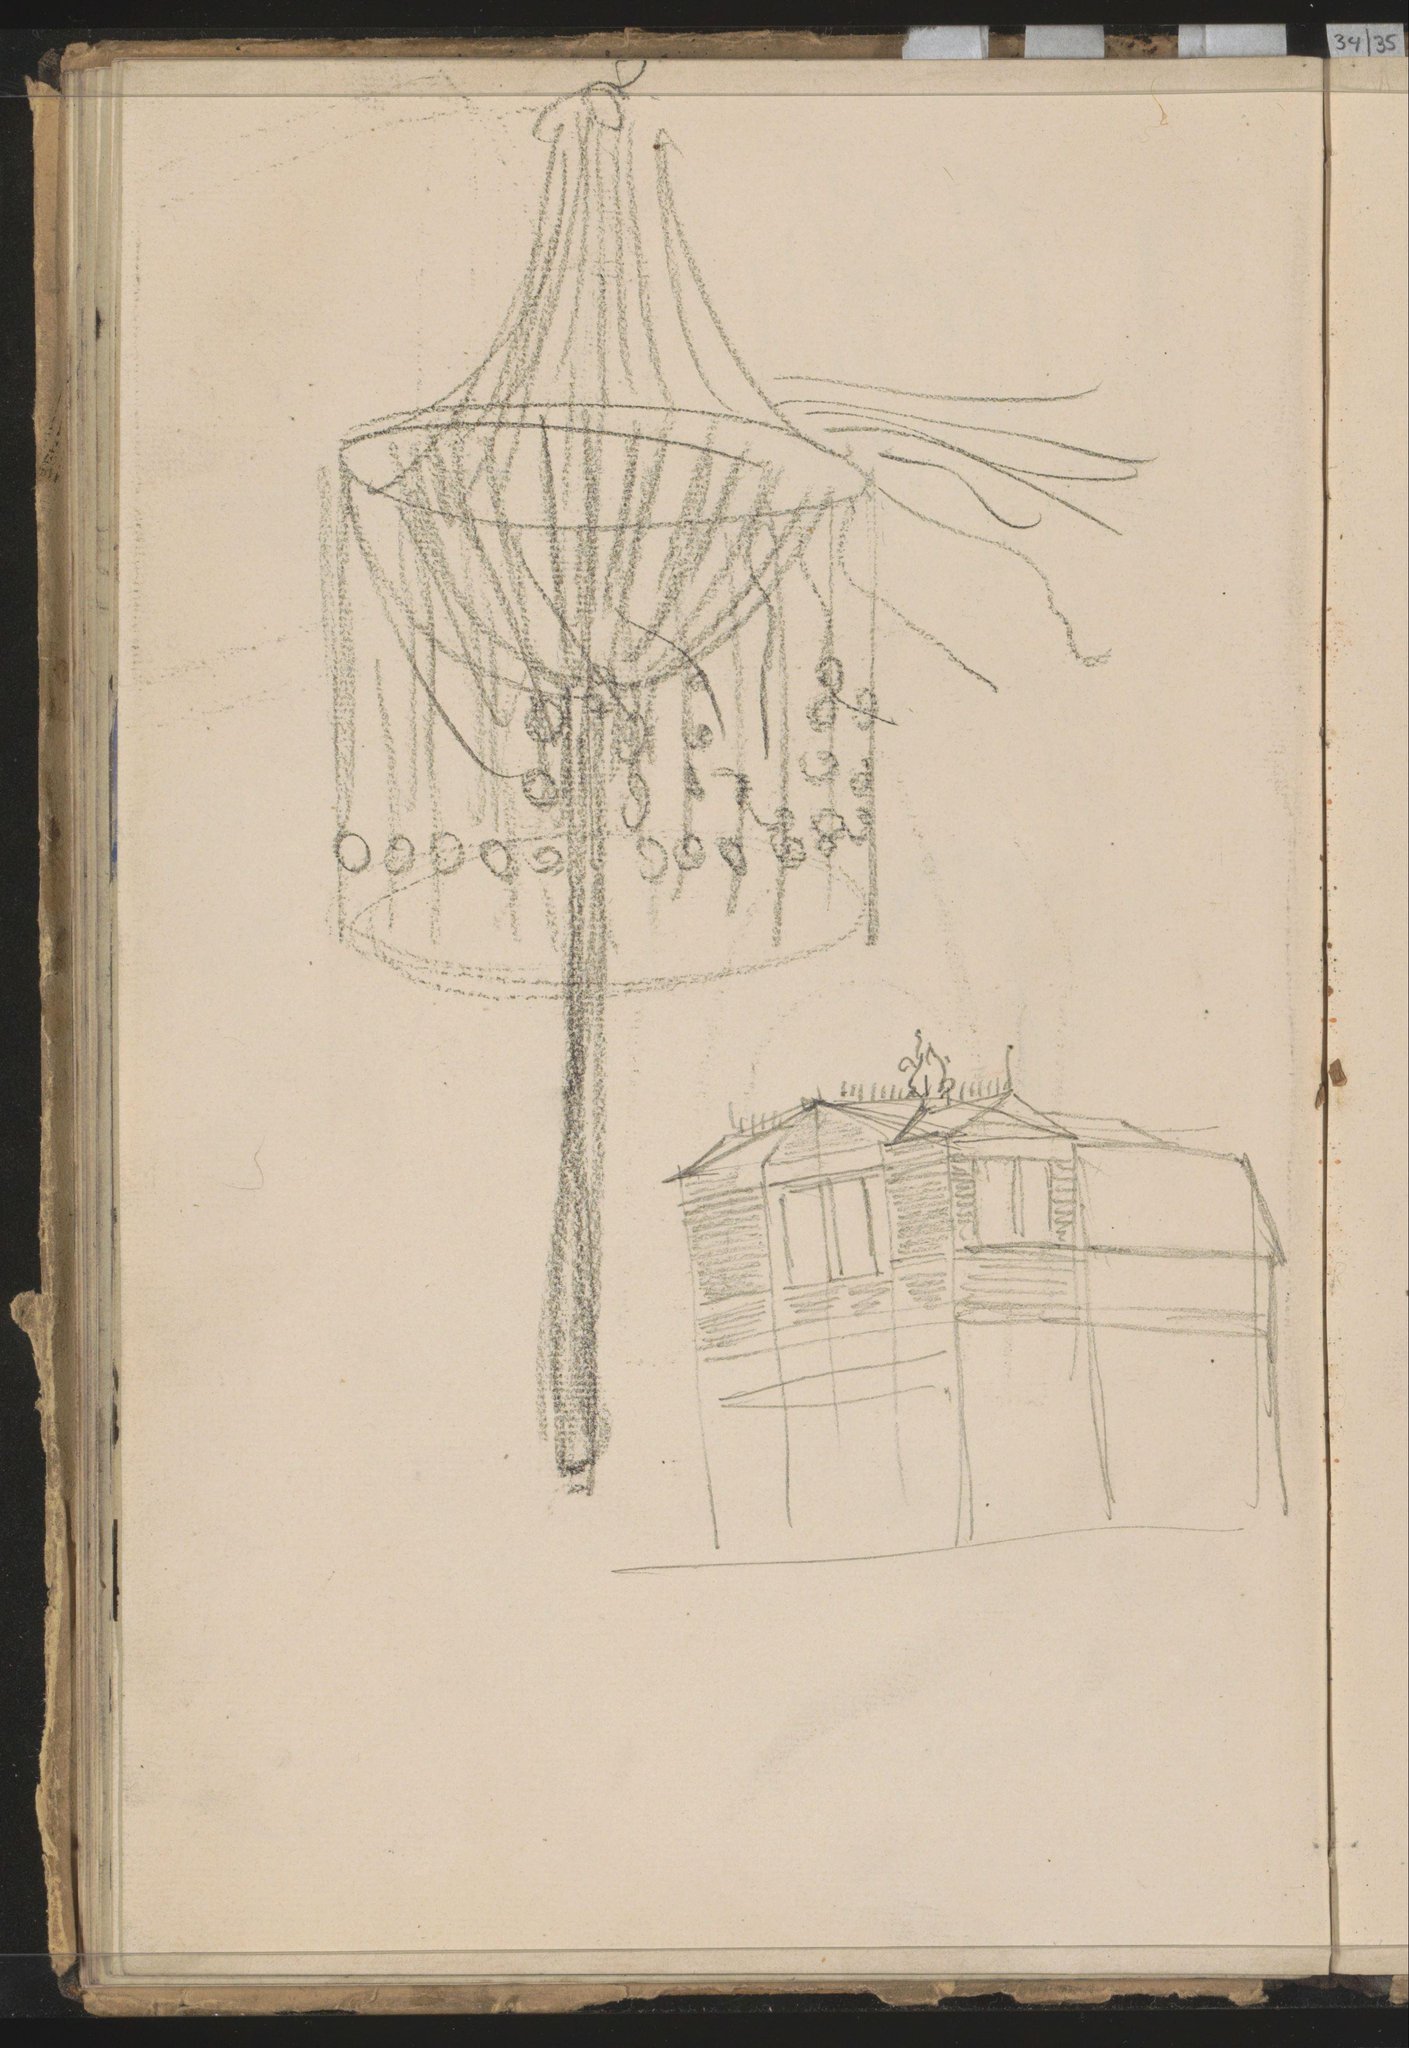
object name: sketchbook leaf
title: Lamp en een architectuurstudie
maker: carel adolph lion cachet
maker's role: draughtsman, print maker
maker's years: 1864-1945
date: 1890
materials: chalk, paper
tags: lighting; lamps, architecture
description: Blad 33 verso uit een schetsboek met 38 bladen.